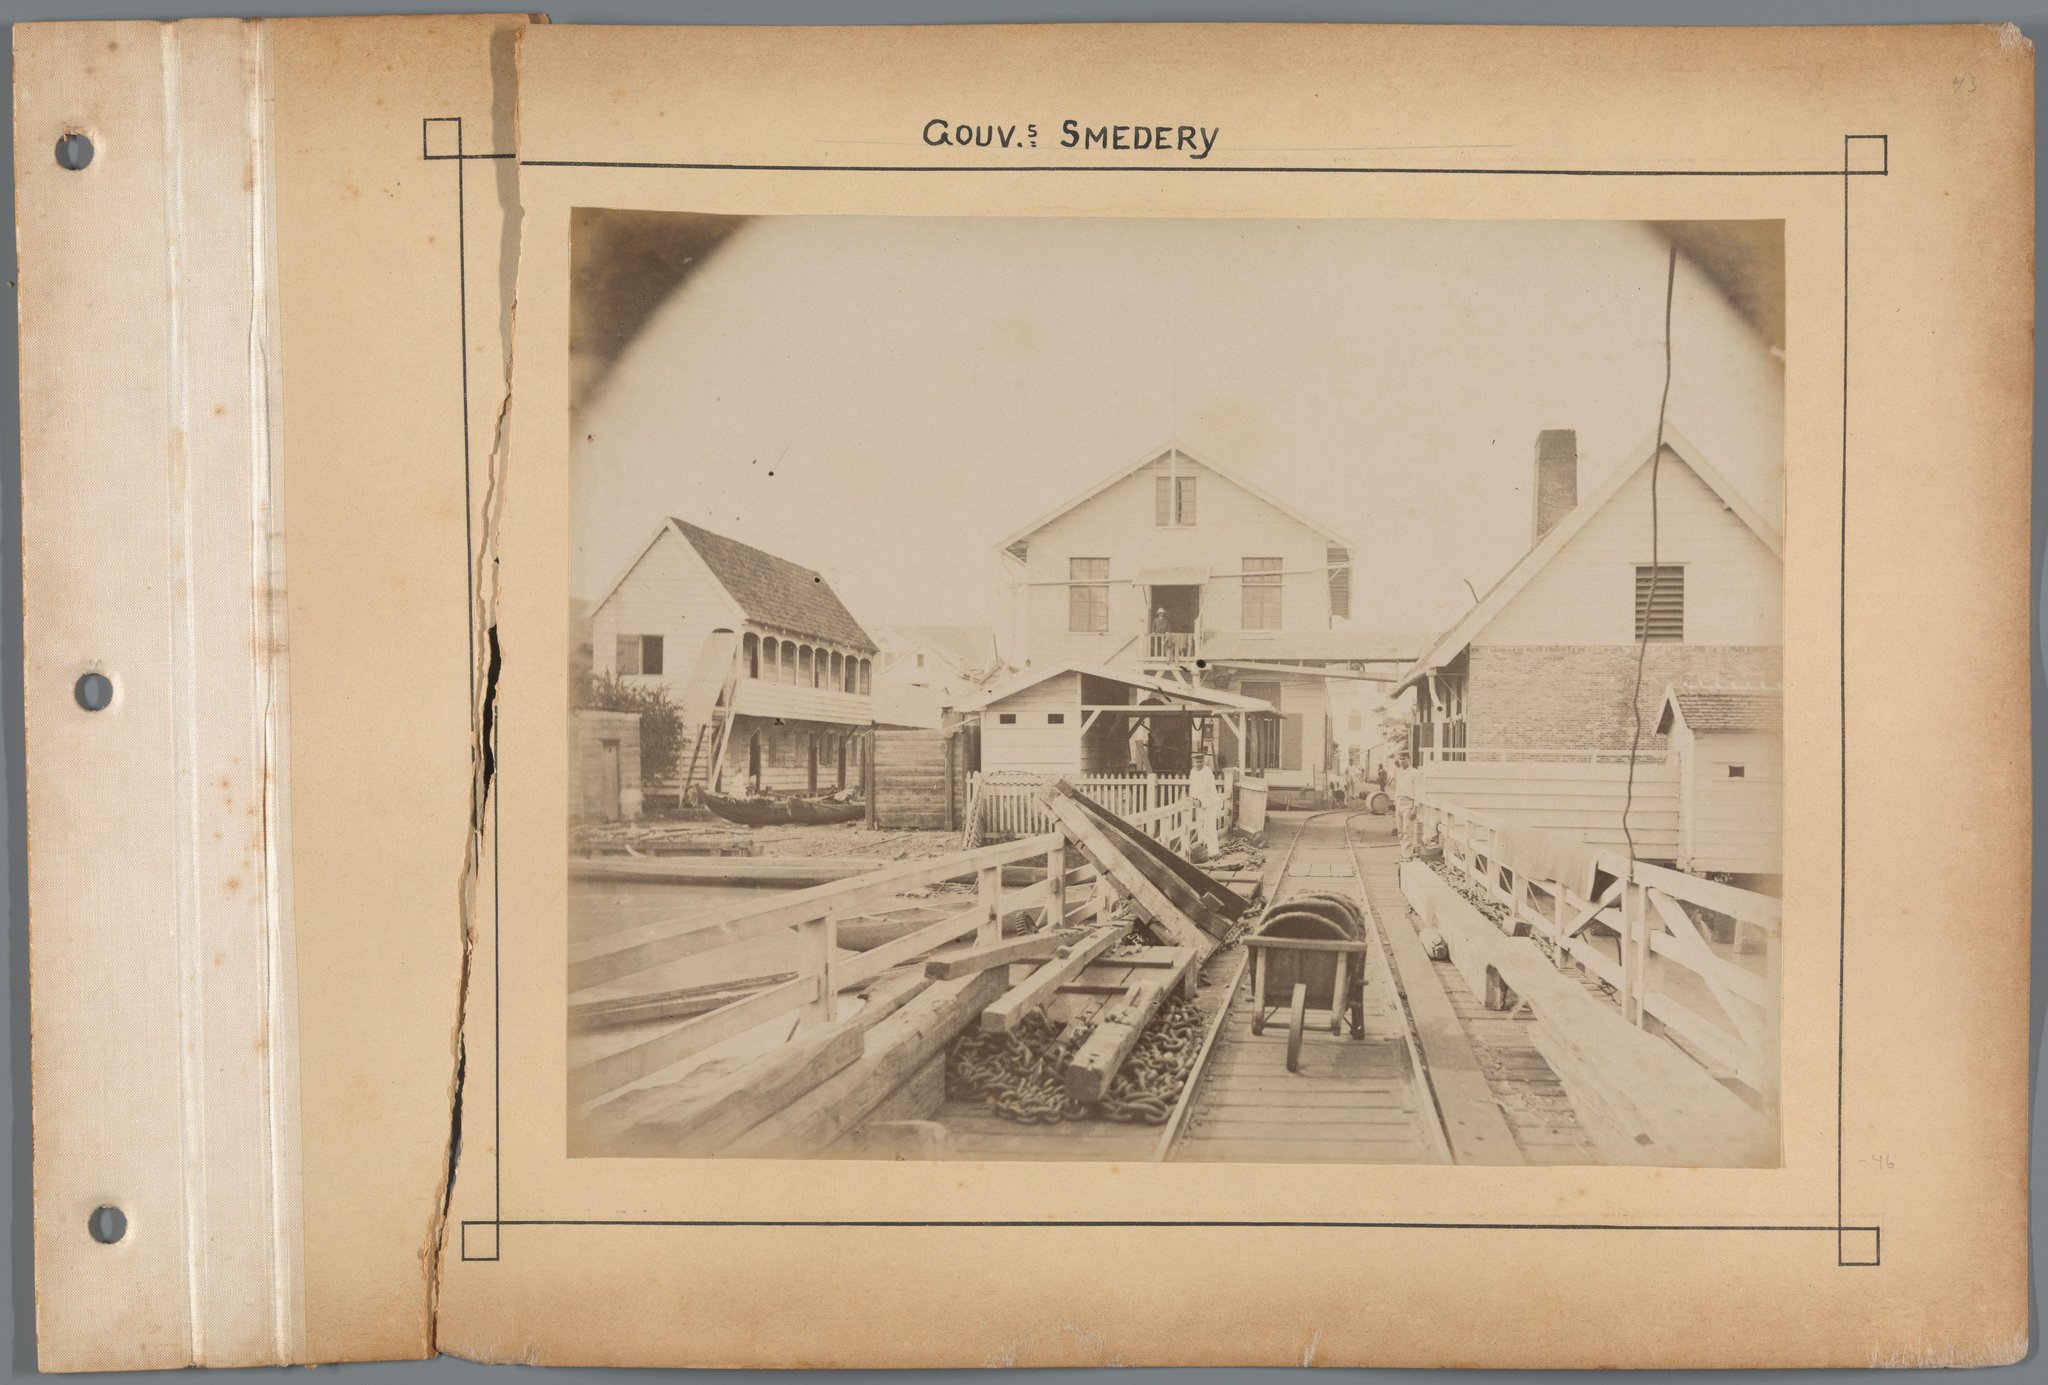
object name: photograph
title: Gouv.s Smedery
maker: julius muller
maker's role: official, politician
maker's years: 1846-1902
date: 1898-1902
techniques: albumen print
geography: suriname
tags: warehouse (~ harbour), suriname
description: Smederij, constructiewinkel (werkplaats) van de koloniale vaartuigen, aan de Waterkant, Paramaribo.